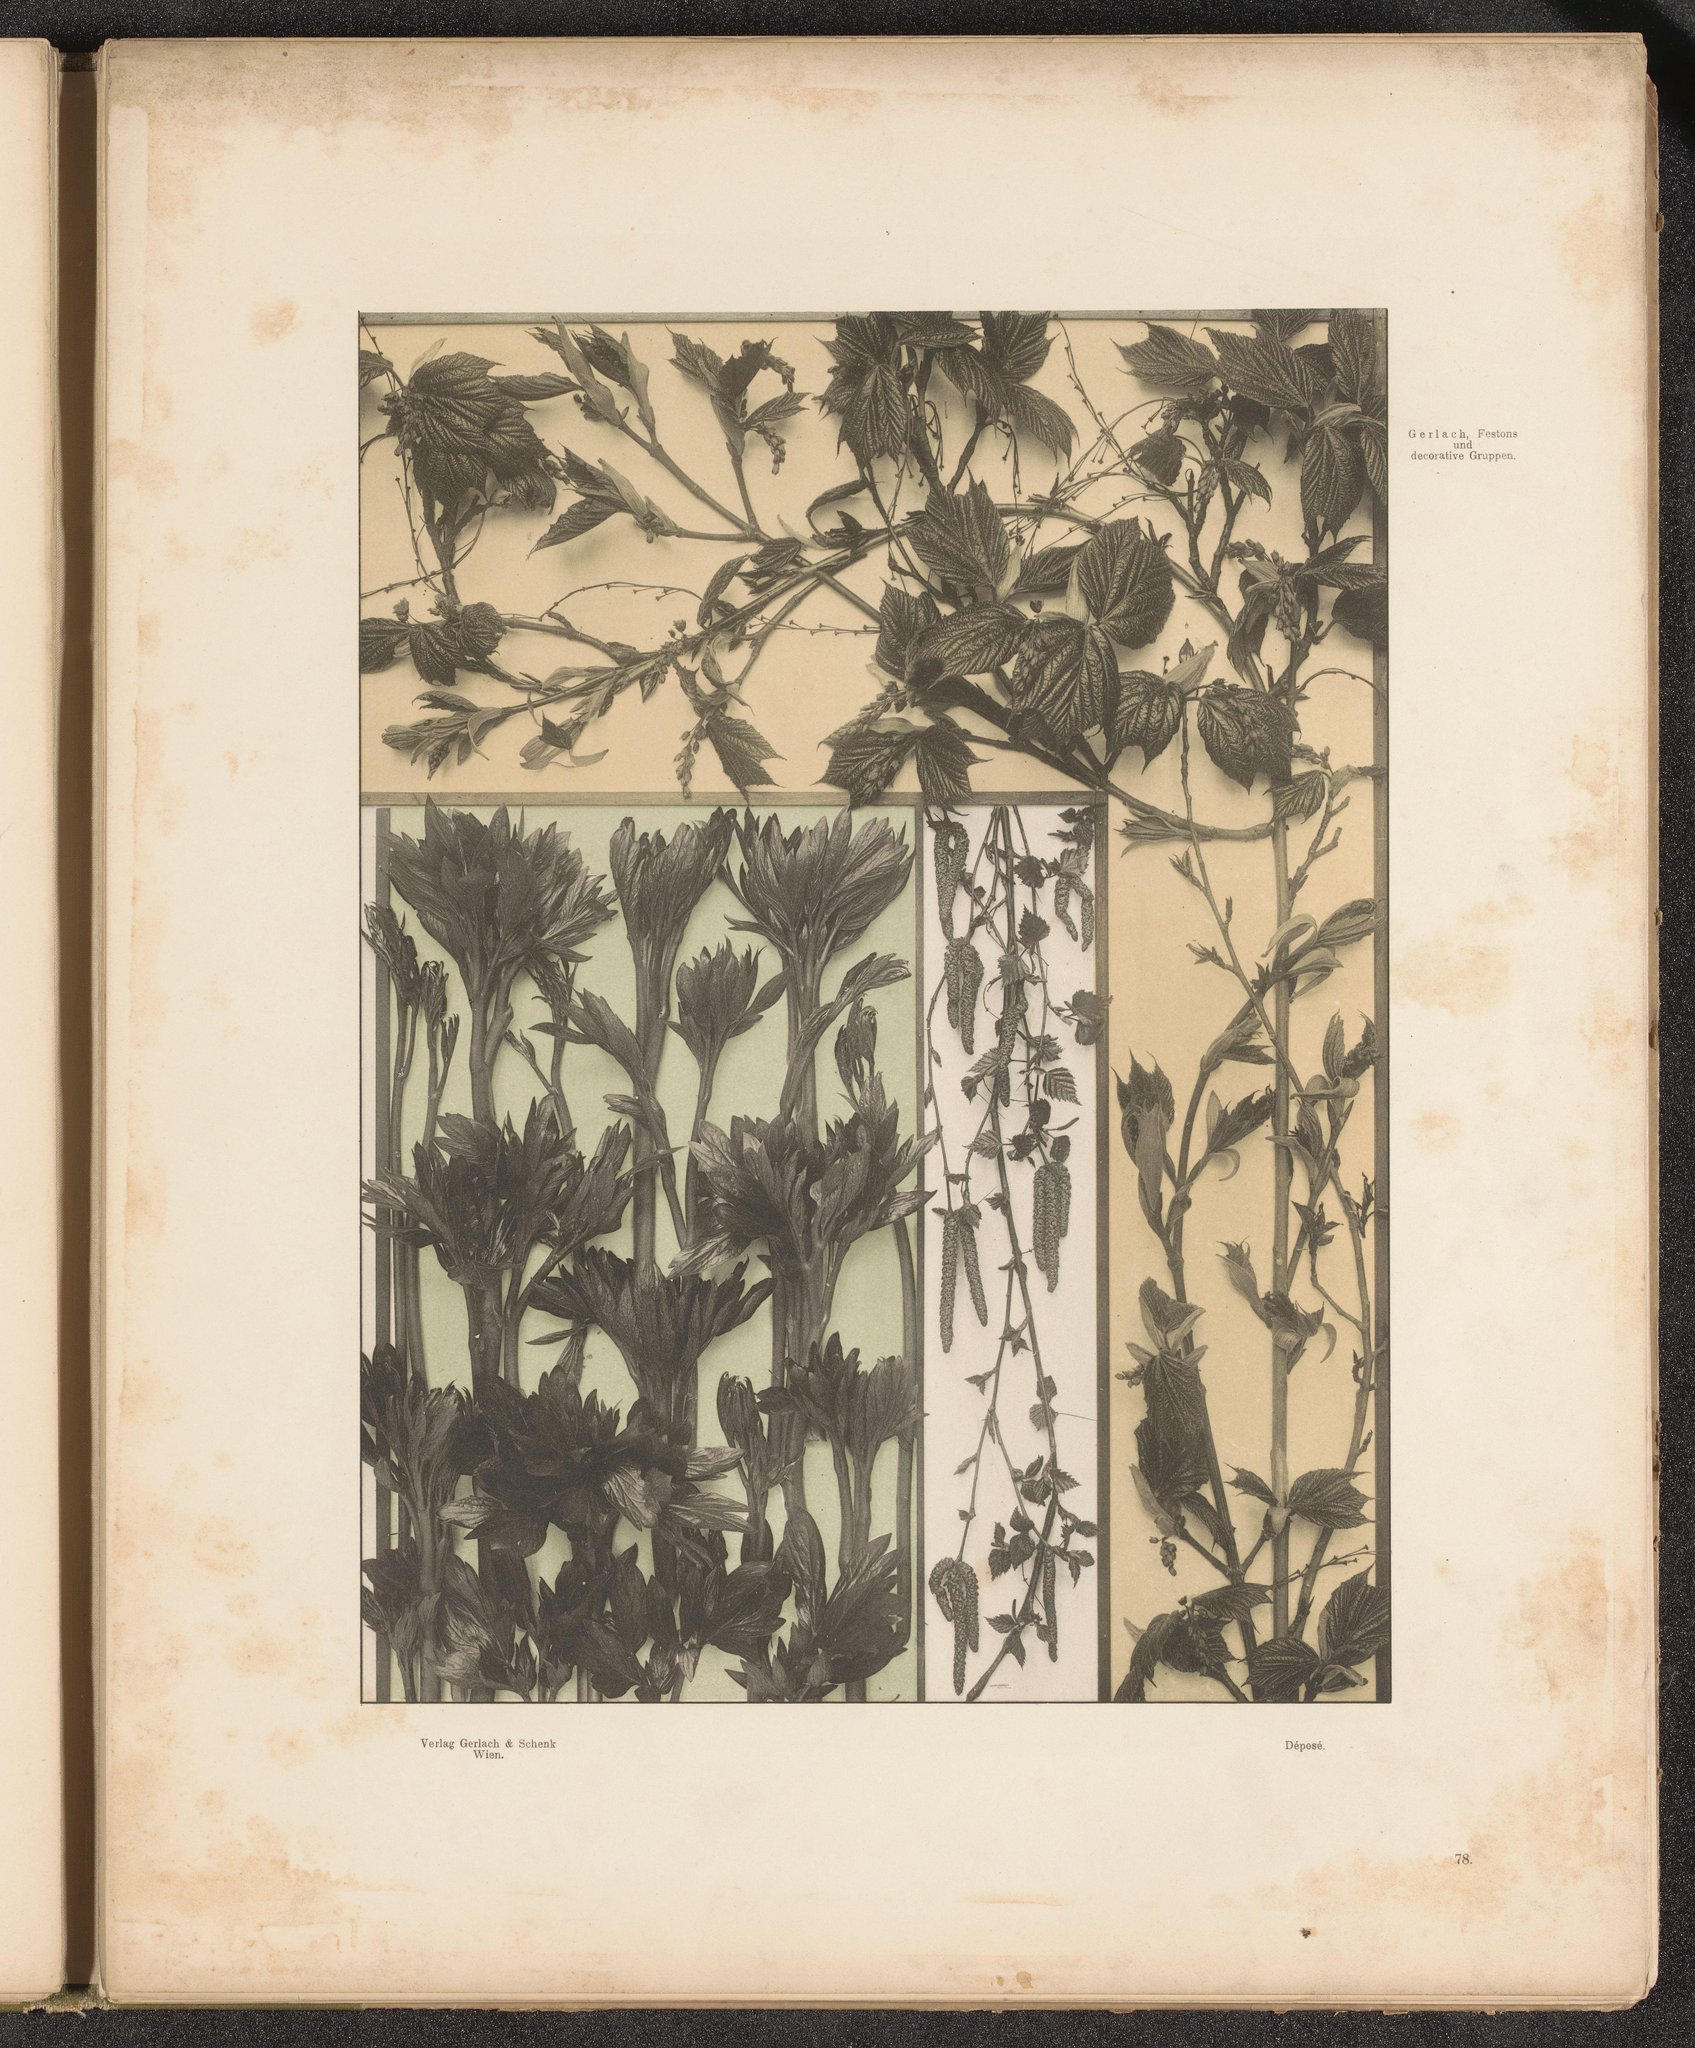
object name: page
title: Vlakken met esdoornbladeren en berkenscheuten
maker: Anonymous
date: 1887-1897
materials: paper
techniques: photograph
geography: austria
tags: foliage, tendrils, branches ~ ornament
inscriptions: number: ‘78.’